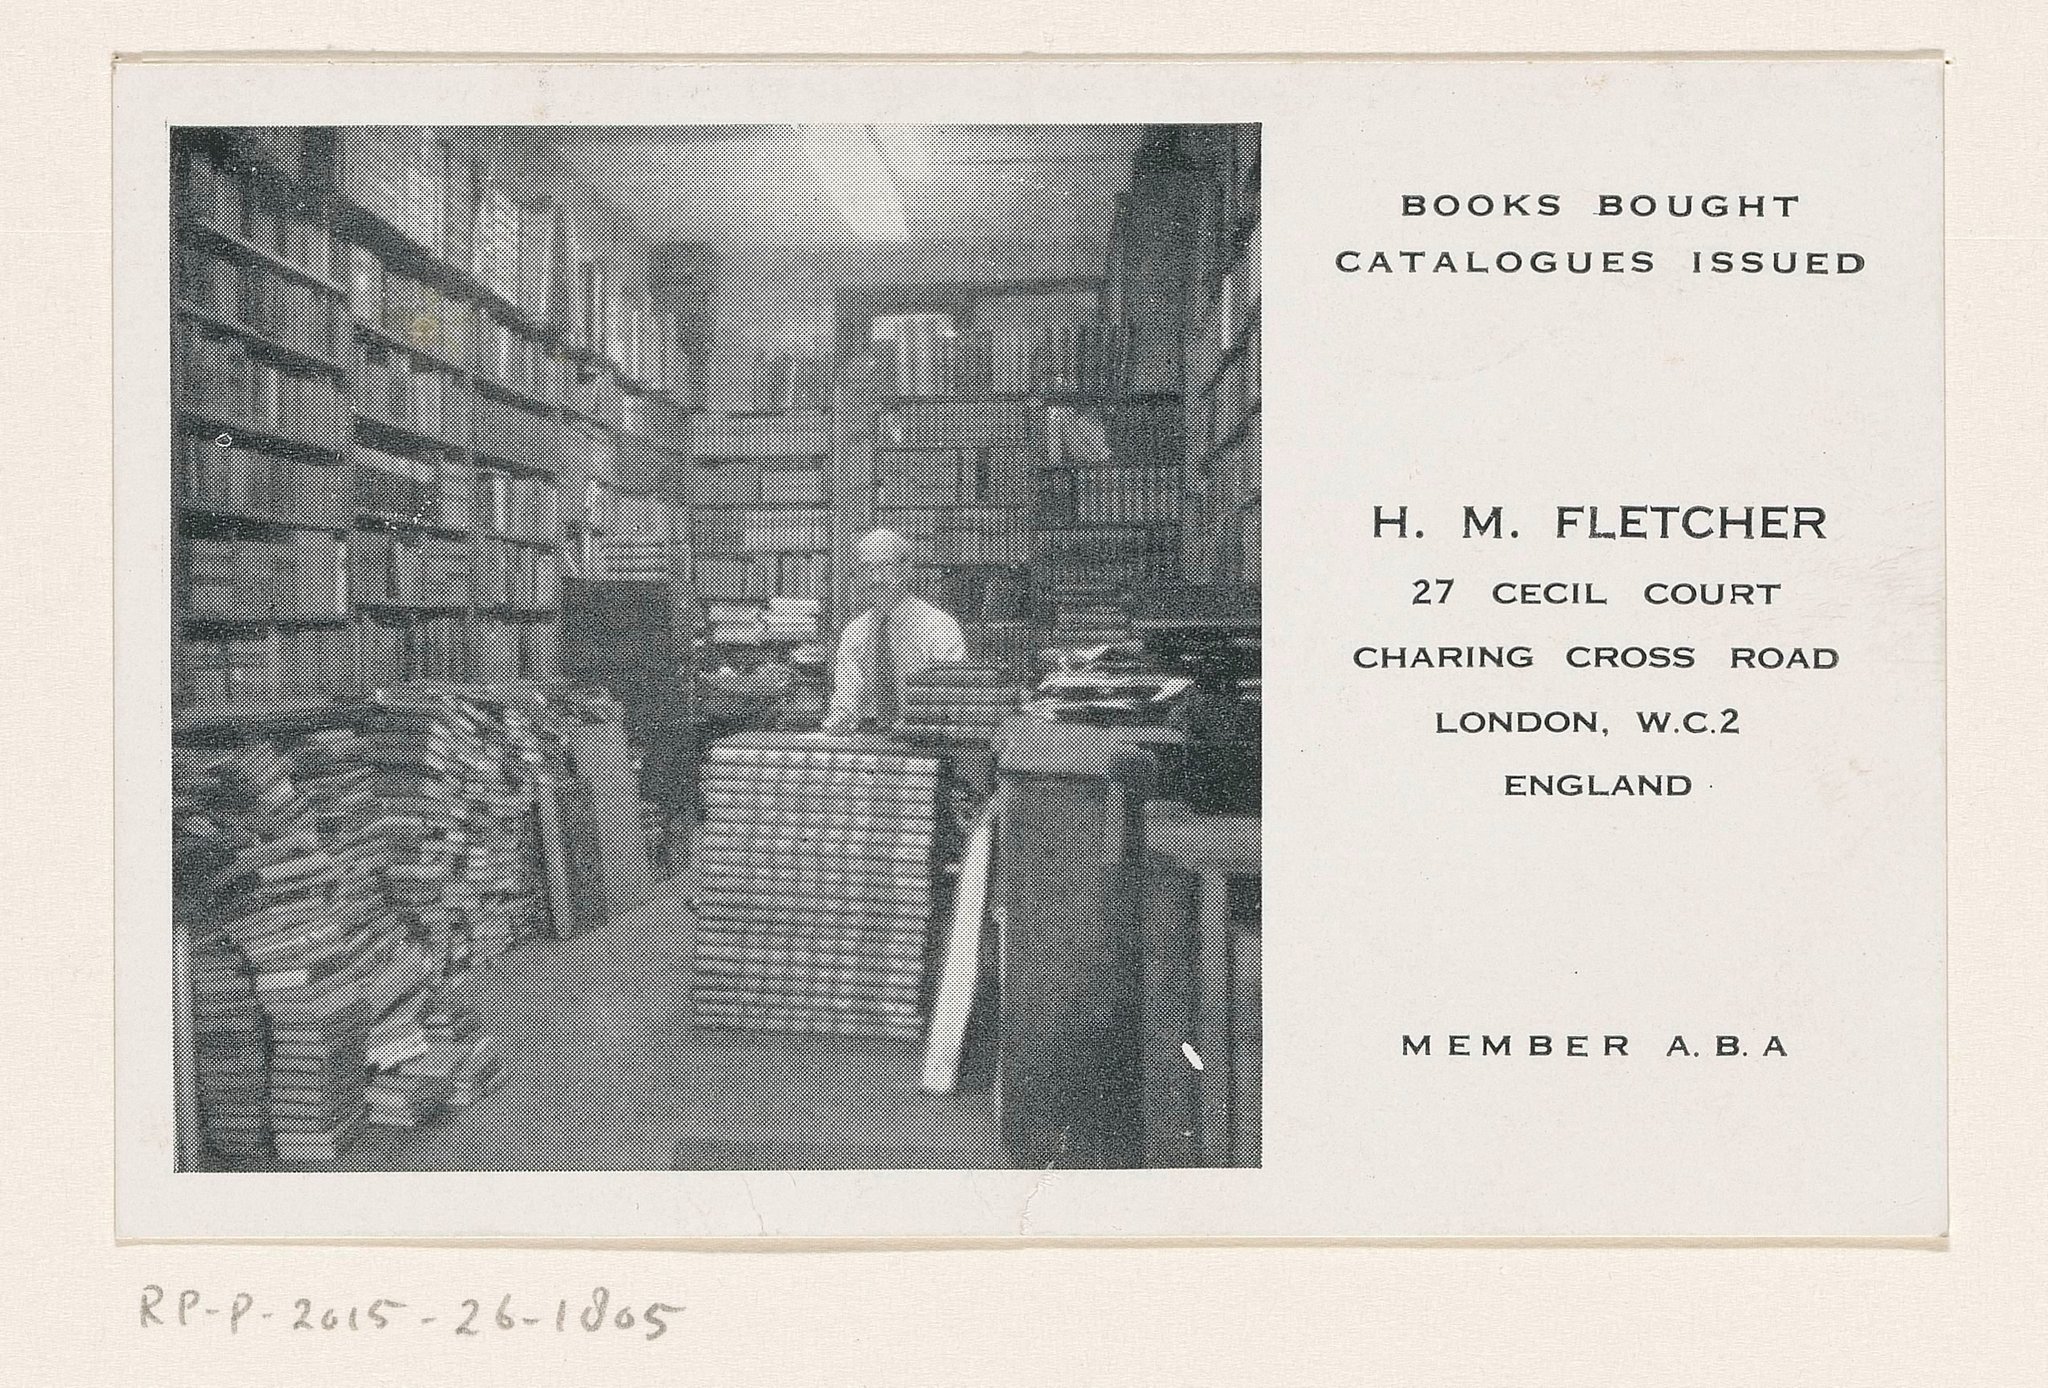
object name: print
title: Visitekaartje van H.M. Fletcher, boekhandelaar te Londen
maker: Anonymous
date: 1950-1996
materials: paper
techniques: autotype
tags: book-shop, bookseller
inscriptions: annotation: ‘Bill Fletche [?]’, annotation: ‘Dear Mr. Hertzberger / It seems to me that the / enclosed is a likely sort of item for you / Quoted to me at £160. / Yours sincerely. / H.M.F.’, collector's mark: Lugt 2228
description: Interieur van de boekhandel met op de grond stapels boeken. Achter een van de stapels staat een man, waarschijnlijk de eigenaar, Bill Fletcher.